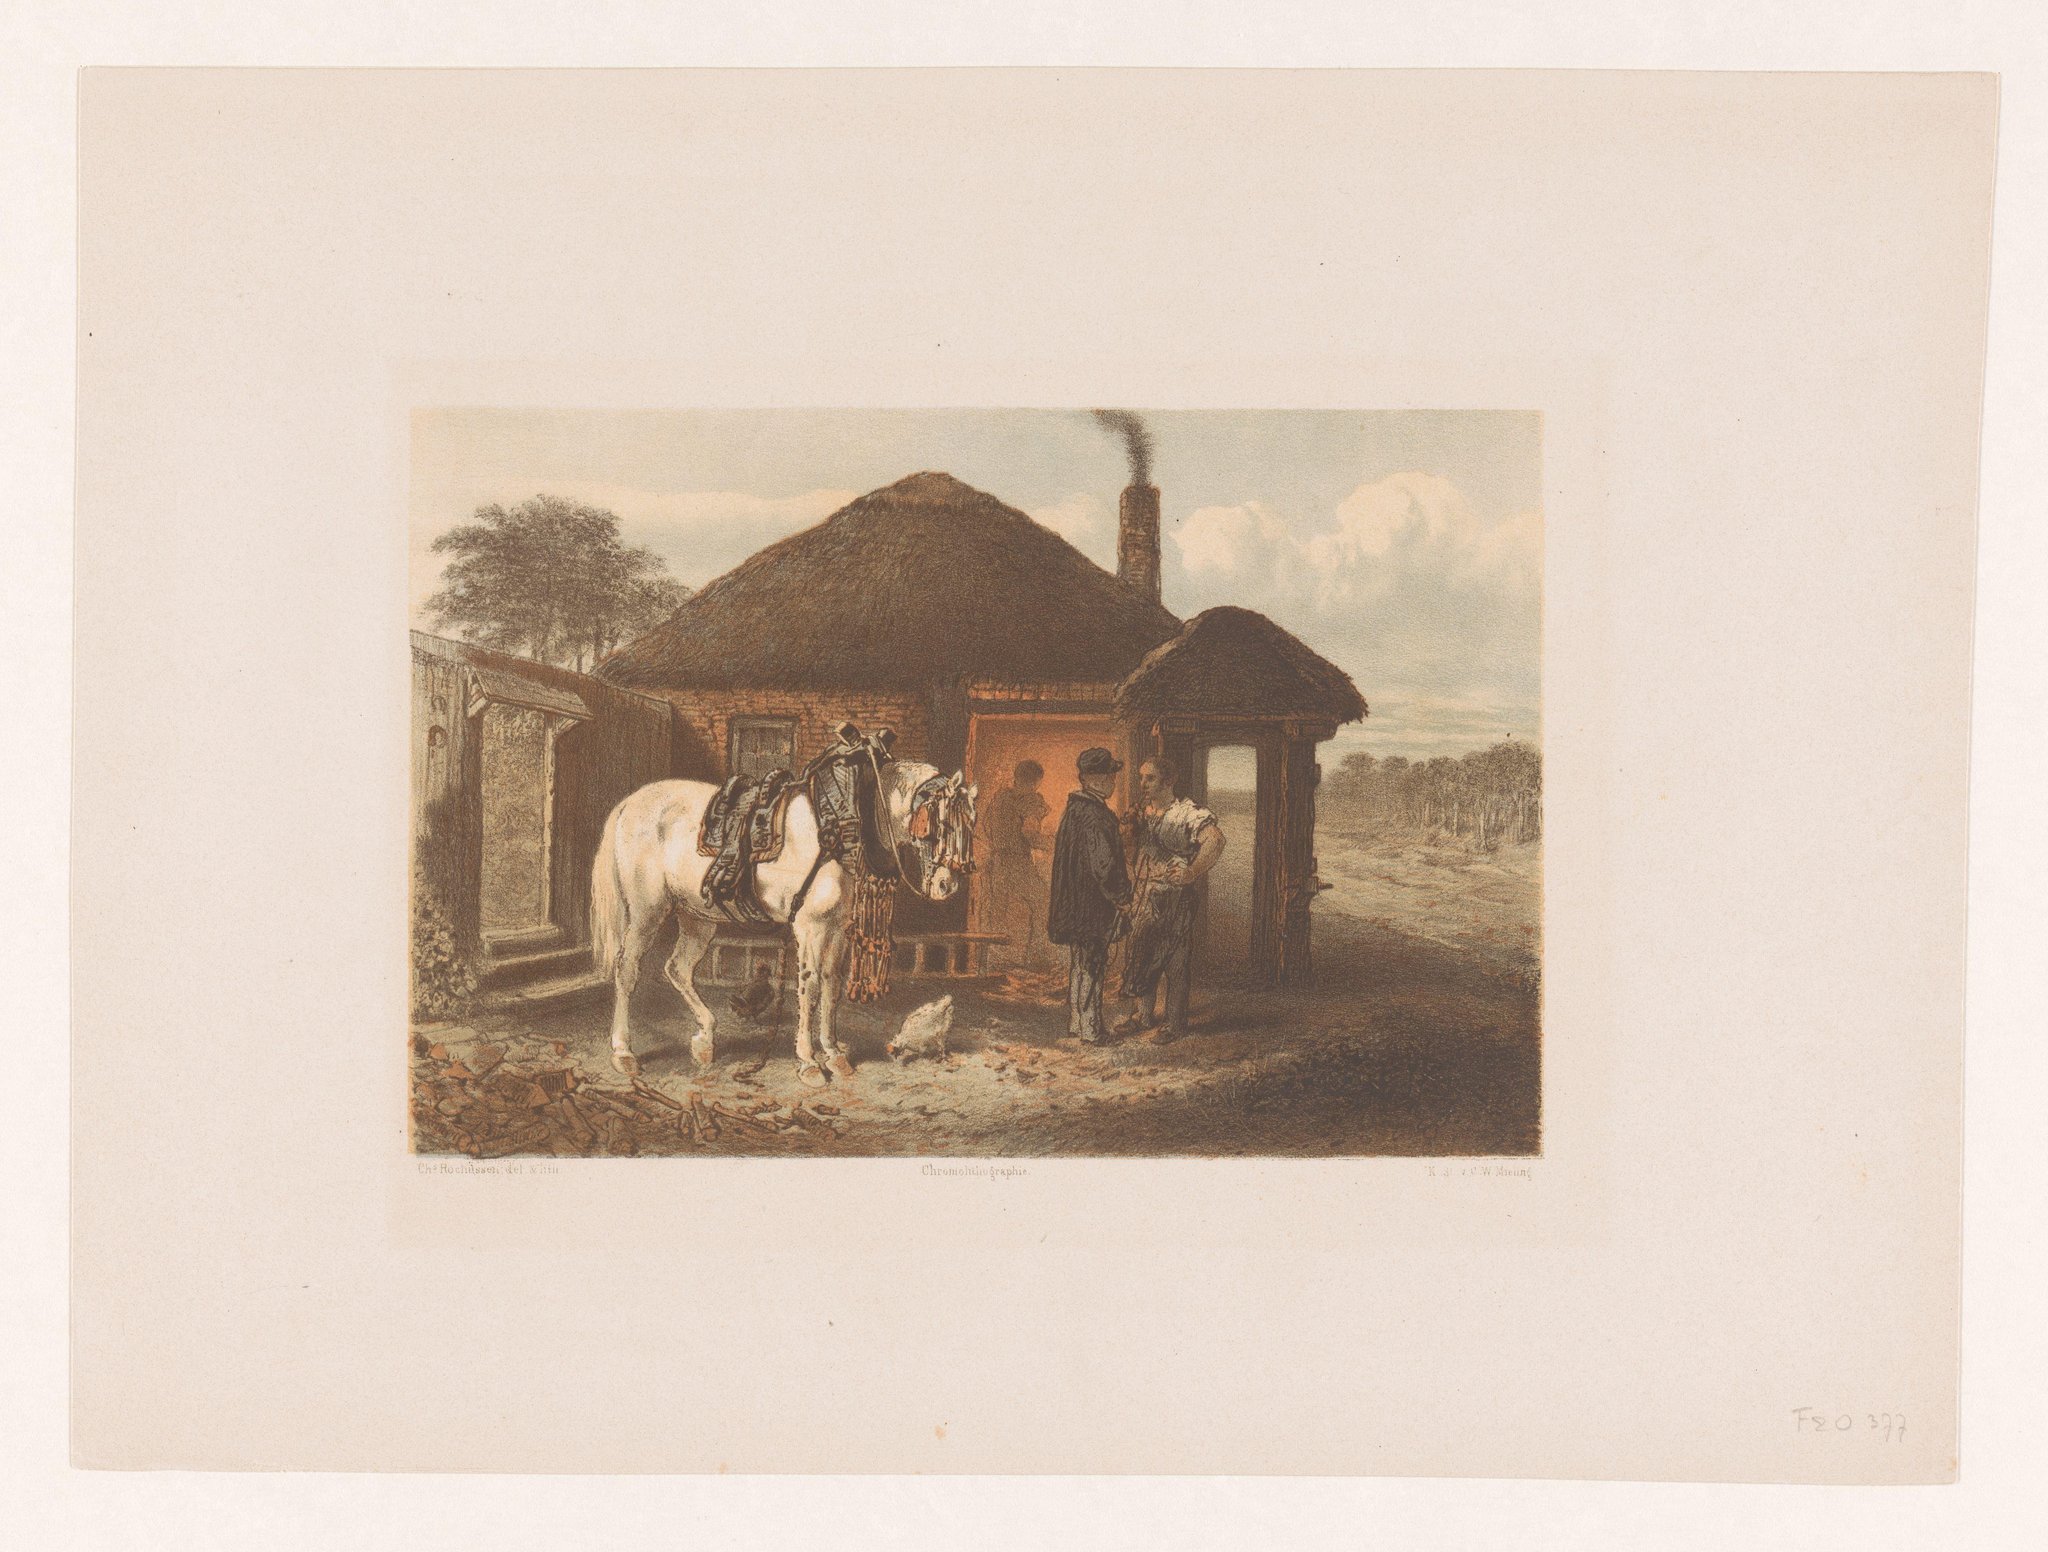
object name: print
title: Hoefsmid in gesprek met man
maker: charles rochussen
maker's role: draughtsman, painter, print maker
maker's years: 1814-1894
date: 1847-1865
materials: paper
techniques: lithograph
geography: the hague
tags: farrier, shoeing-smith, horse, conversation, dialogue; conversation piece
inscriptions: collector's mark: Lugt 2228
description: Een hoefsmid in gesprek met een (voer)man met zweep. Links staat een opgetuigd paard. In de achtergrond is een hoefsmid aan het werk in de werkplaats.